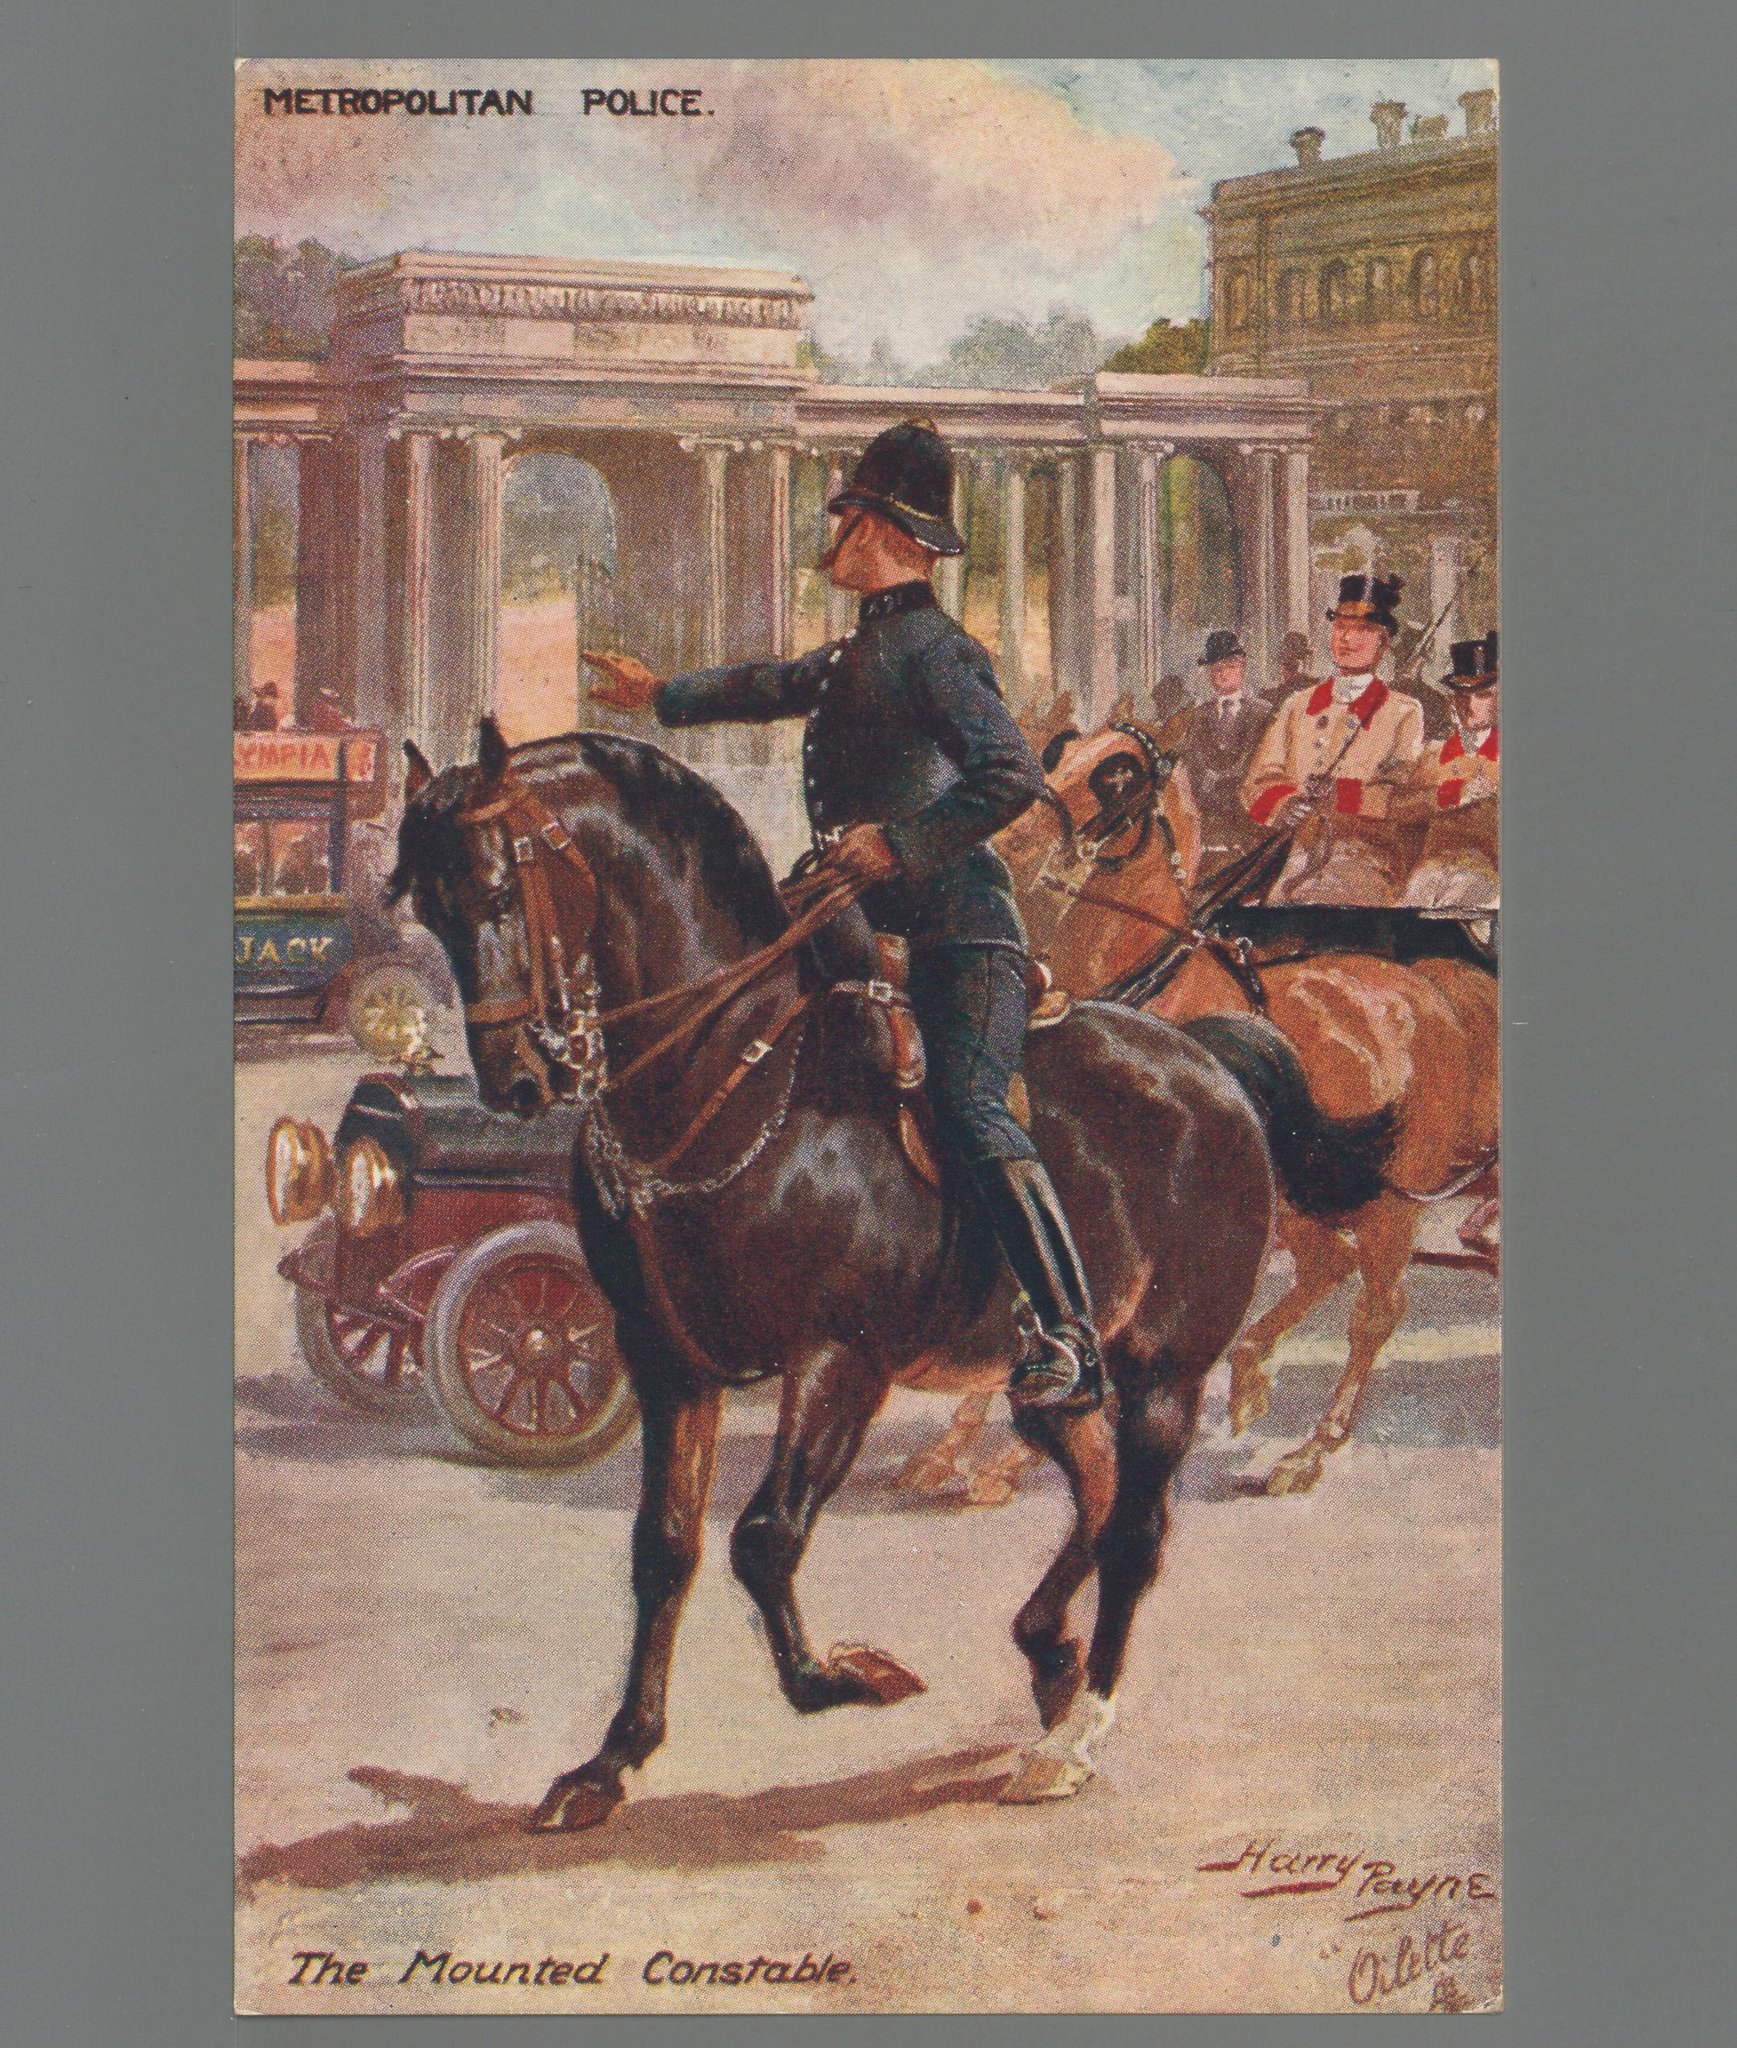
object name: reproduction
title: The Metropolitan & City Police (London)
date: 1911-1914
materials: cardboard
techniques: color autotype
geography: england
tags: policeman, constable, horse, london